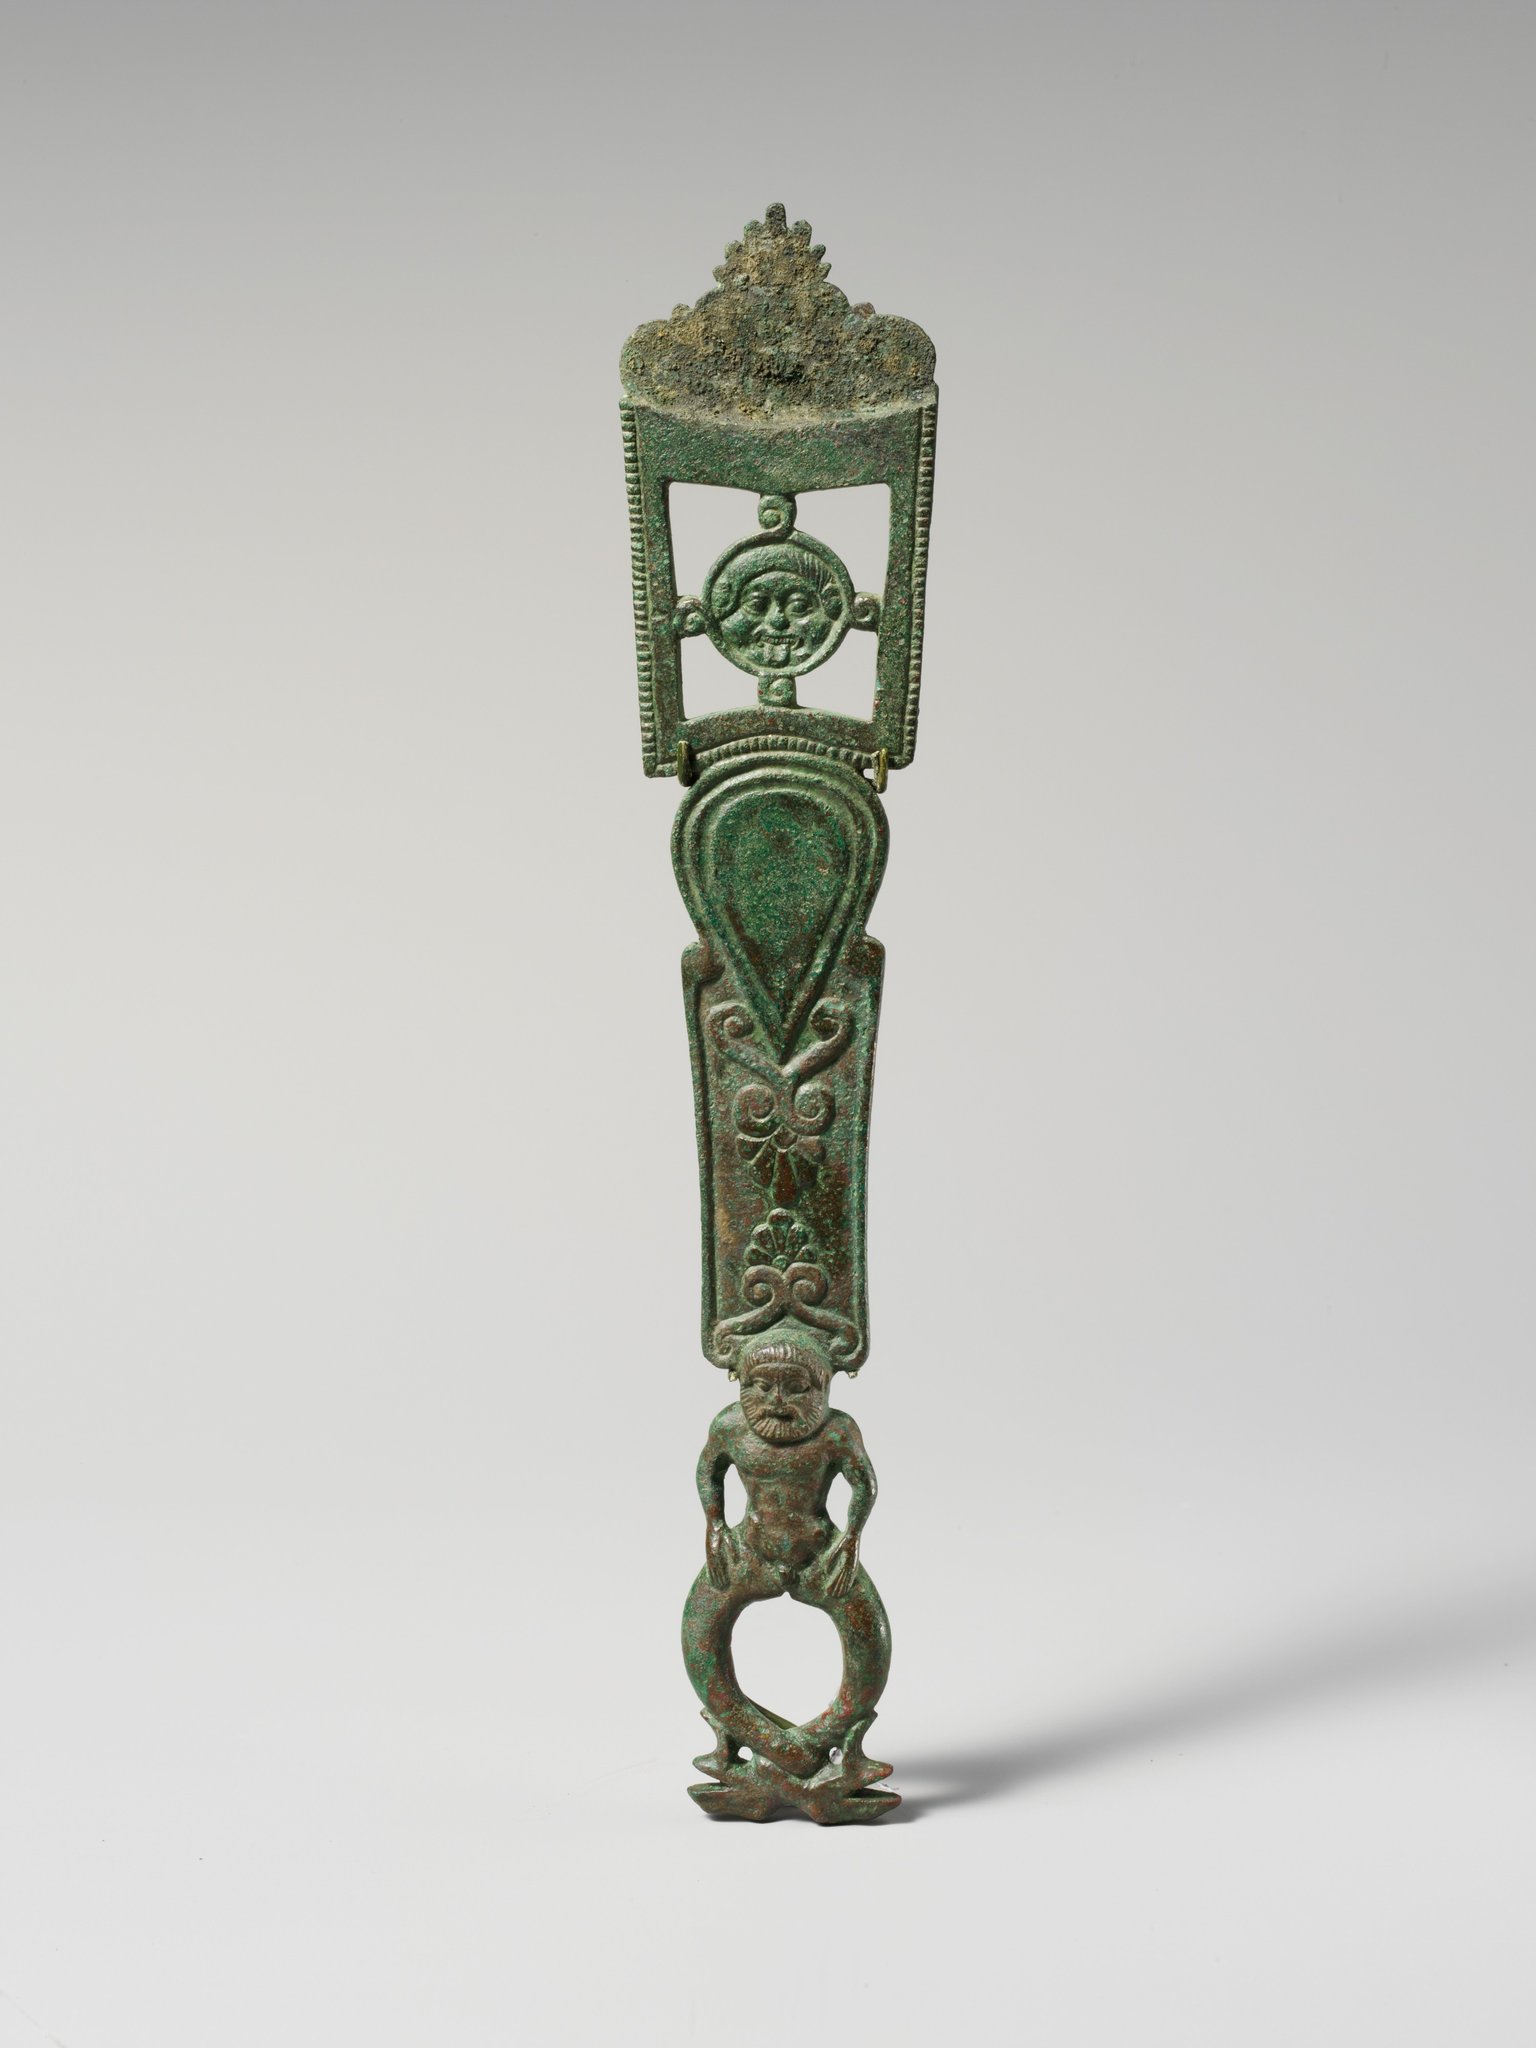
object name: strainer handle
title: Bronze handle of a strainer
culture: etruscan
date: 500-401 BCE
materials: bronze